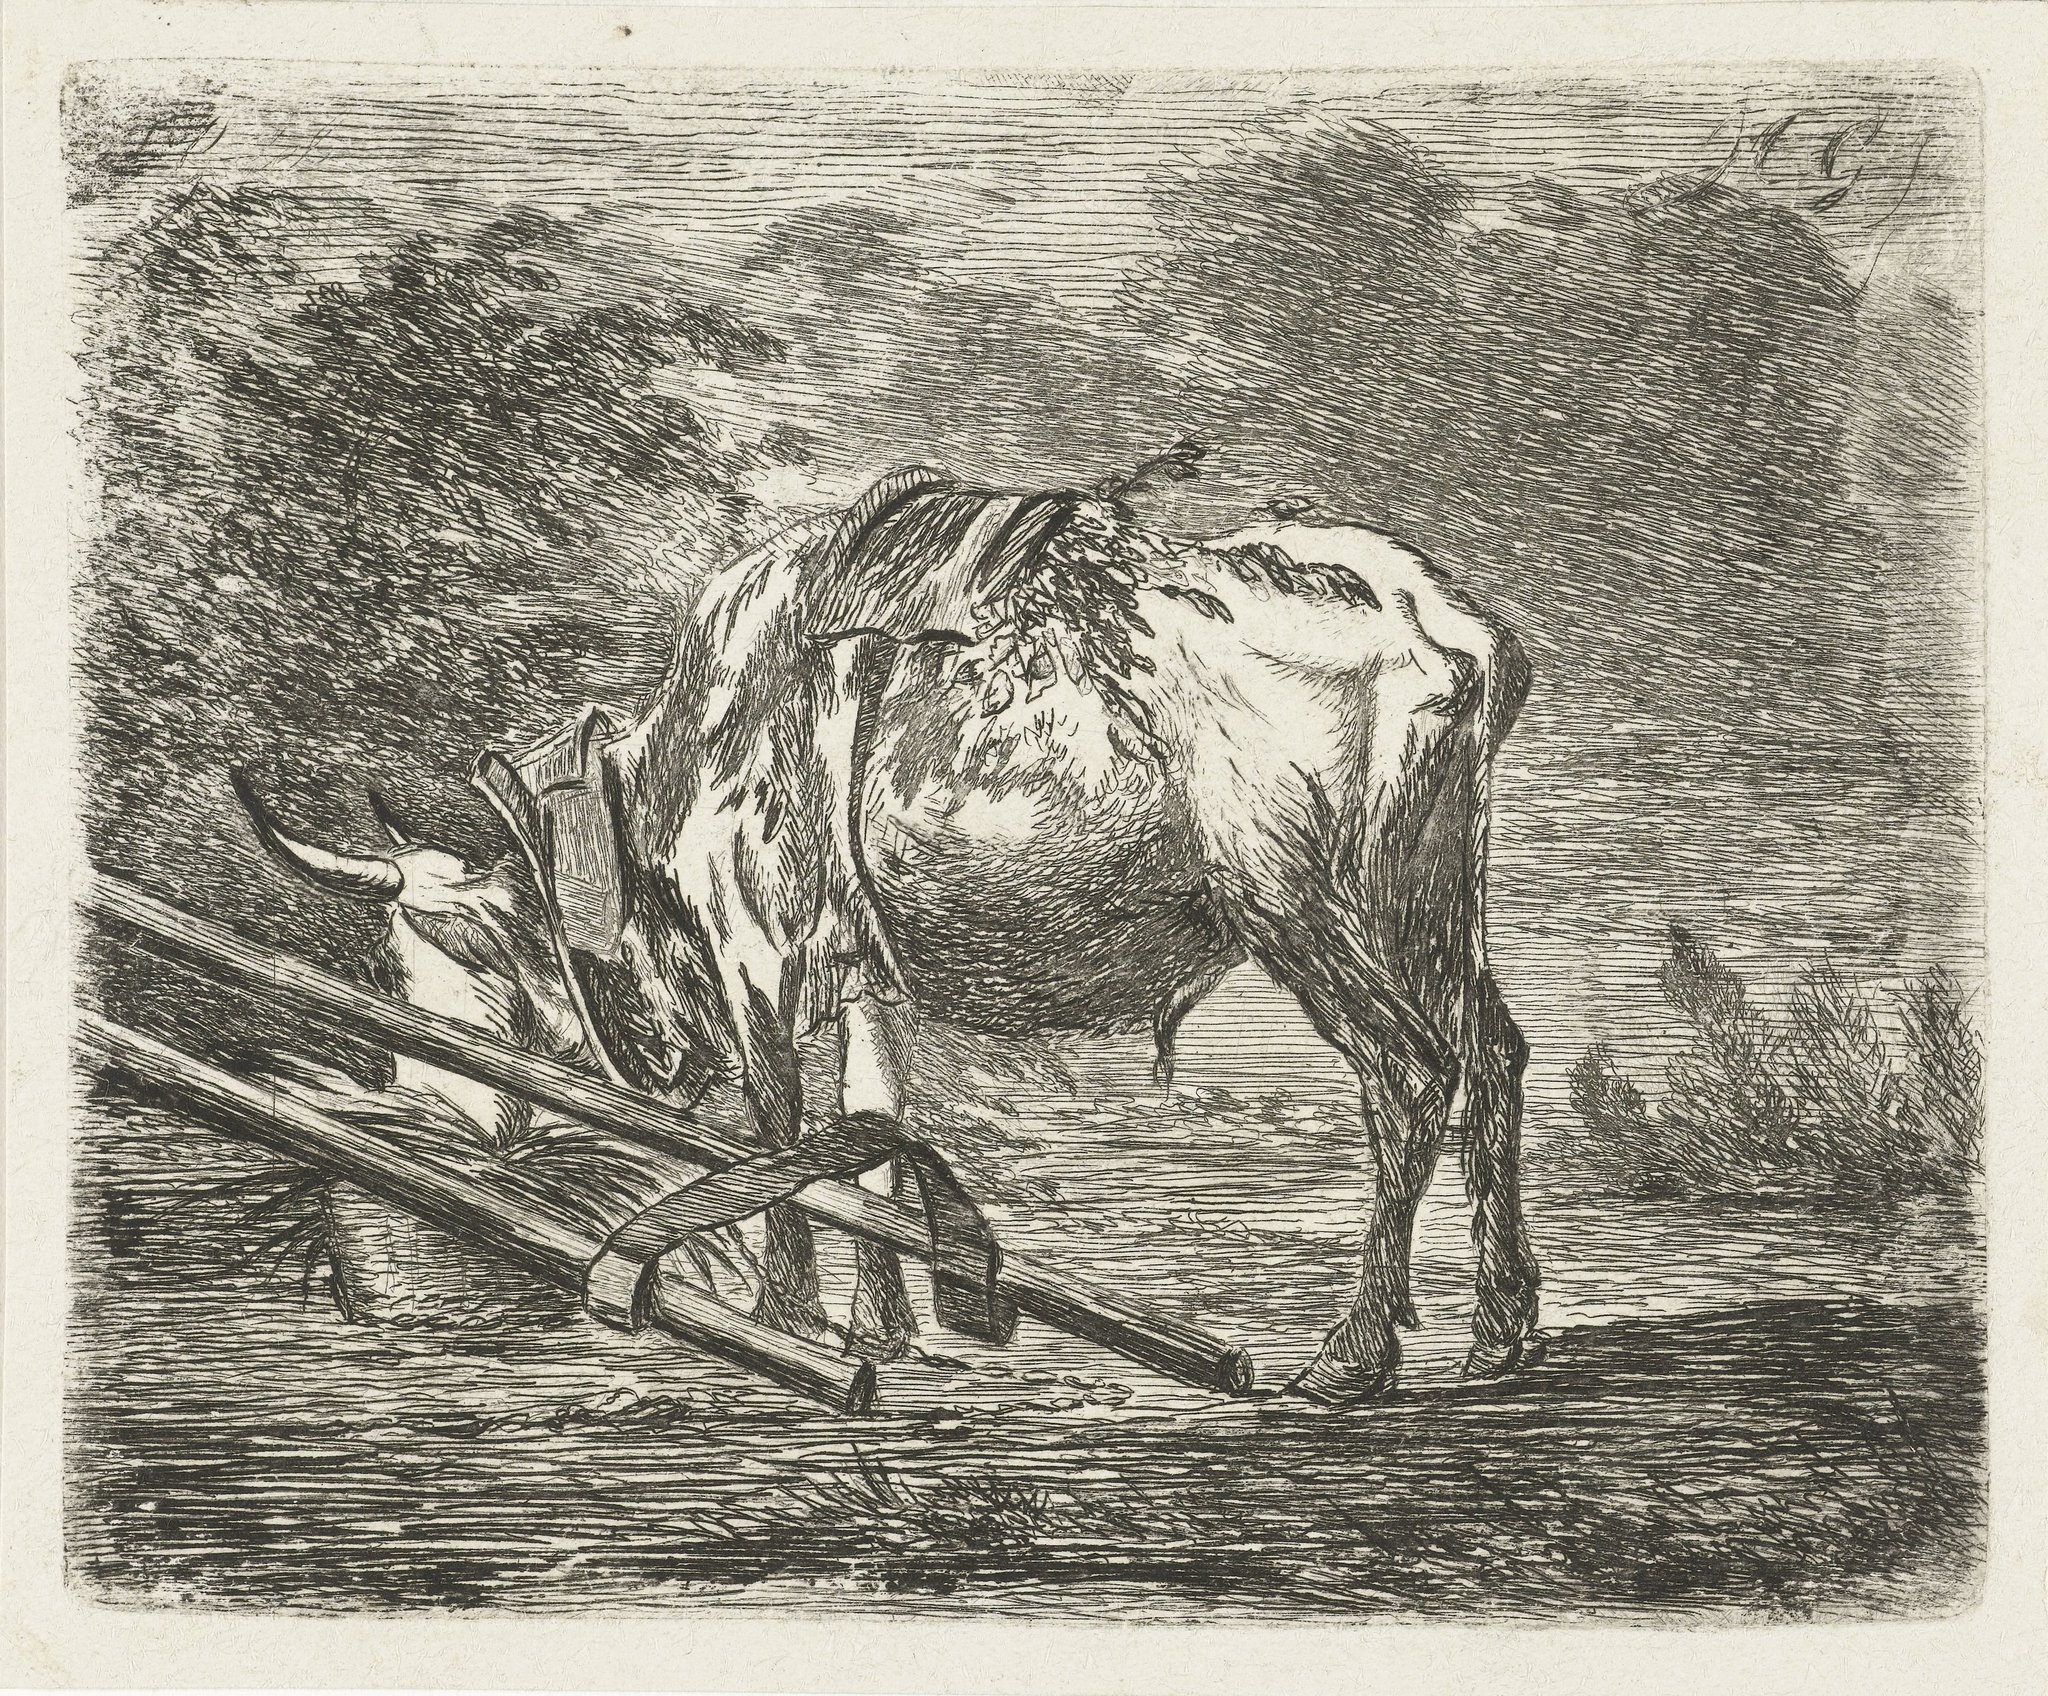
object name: print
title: Trekos met juk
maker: jacobus cornelis gaal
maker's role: print maker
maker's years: 1796-1866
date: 1860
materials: paper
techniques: etching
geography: netherlands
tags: ox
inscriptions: collector's mark: Lugt 2228